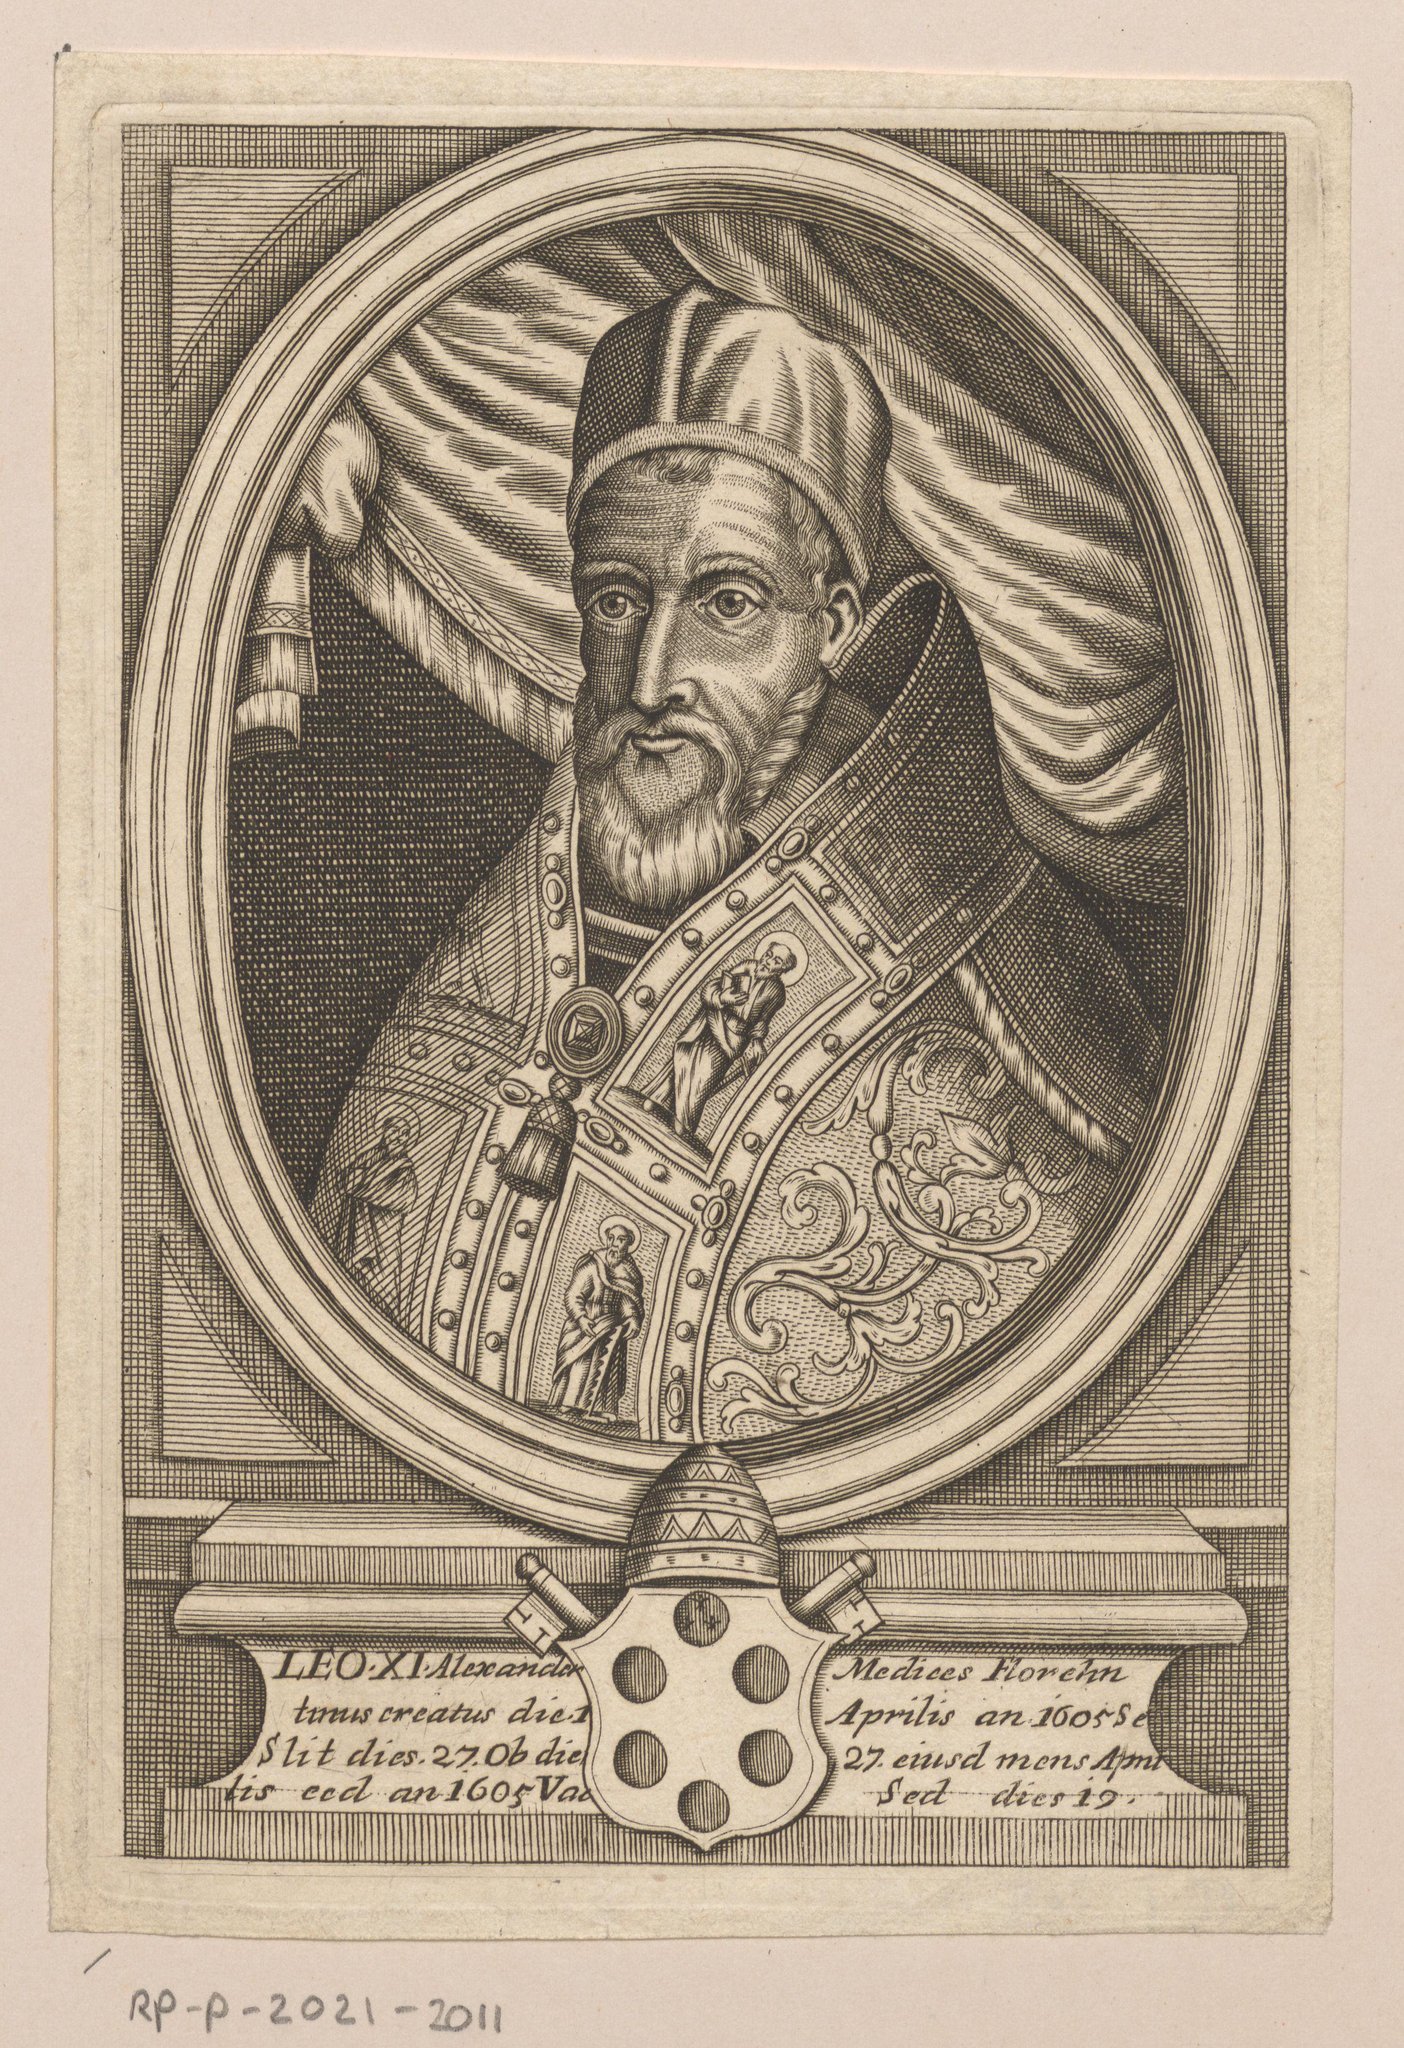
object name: print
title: Portret van paus Leo XI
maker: Anonymous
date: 1650-1700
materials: paper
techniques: engraving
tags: leo xi, ornament ~ medallion, insignia of the pope, e.g. tiara, historical persons, pope, armorial bearing, heraldry